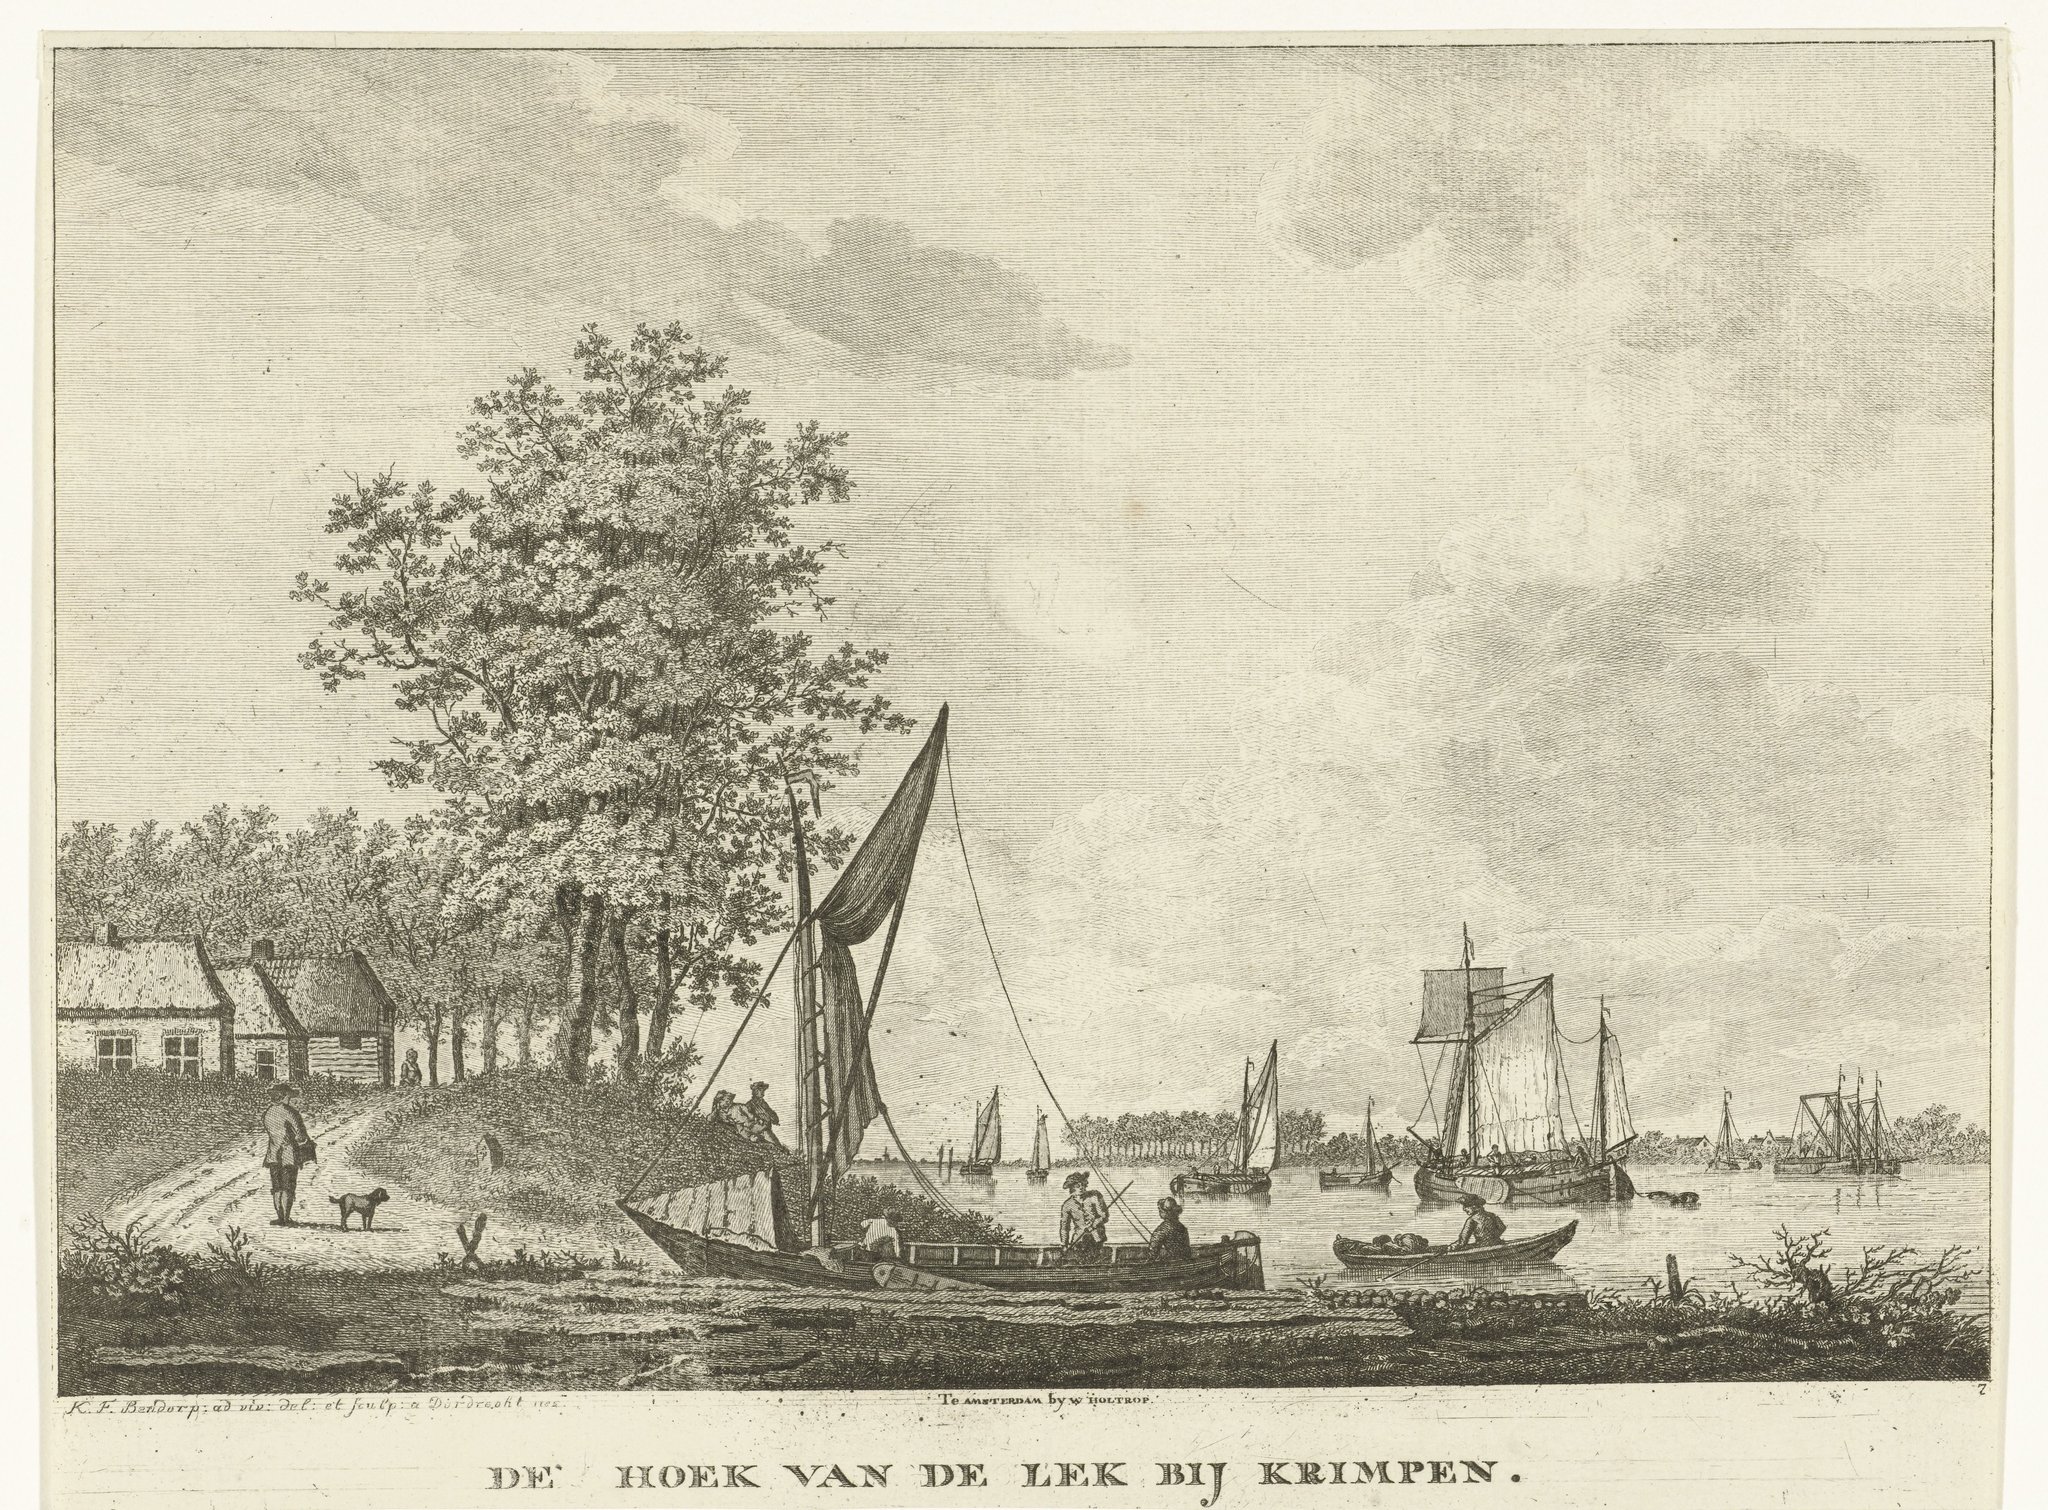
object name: print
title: De hoek van de Lek bij Krimpen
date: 1785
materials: paper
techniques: etching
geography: amsterdam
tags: river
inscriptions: collector's mark: Lugt 2228